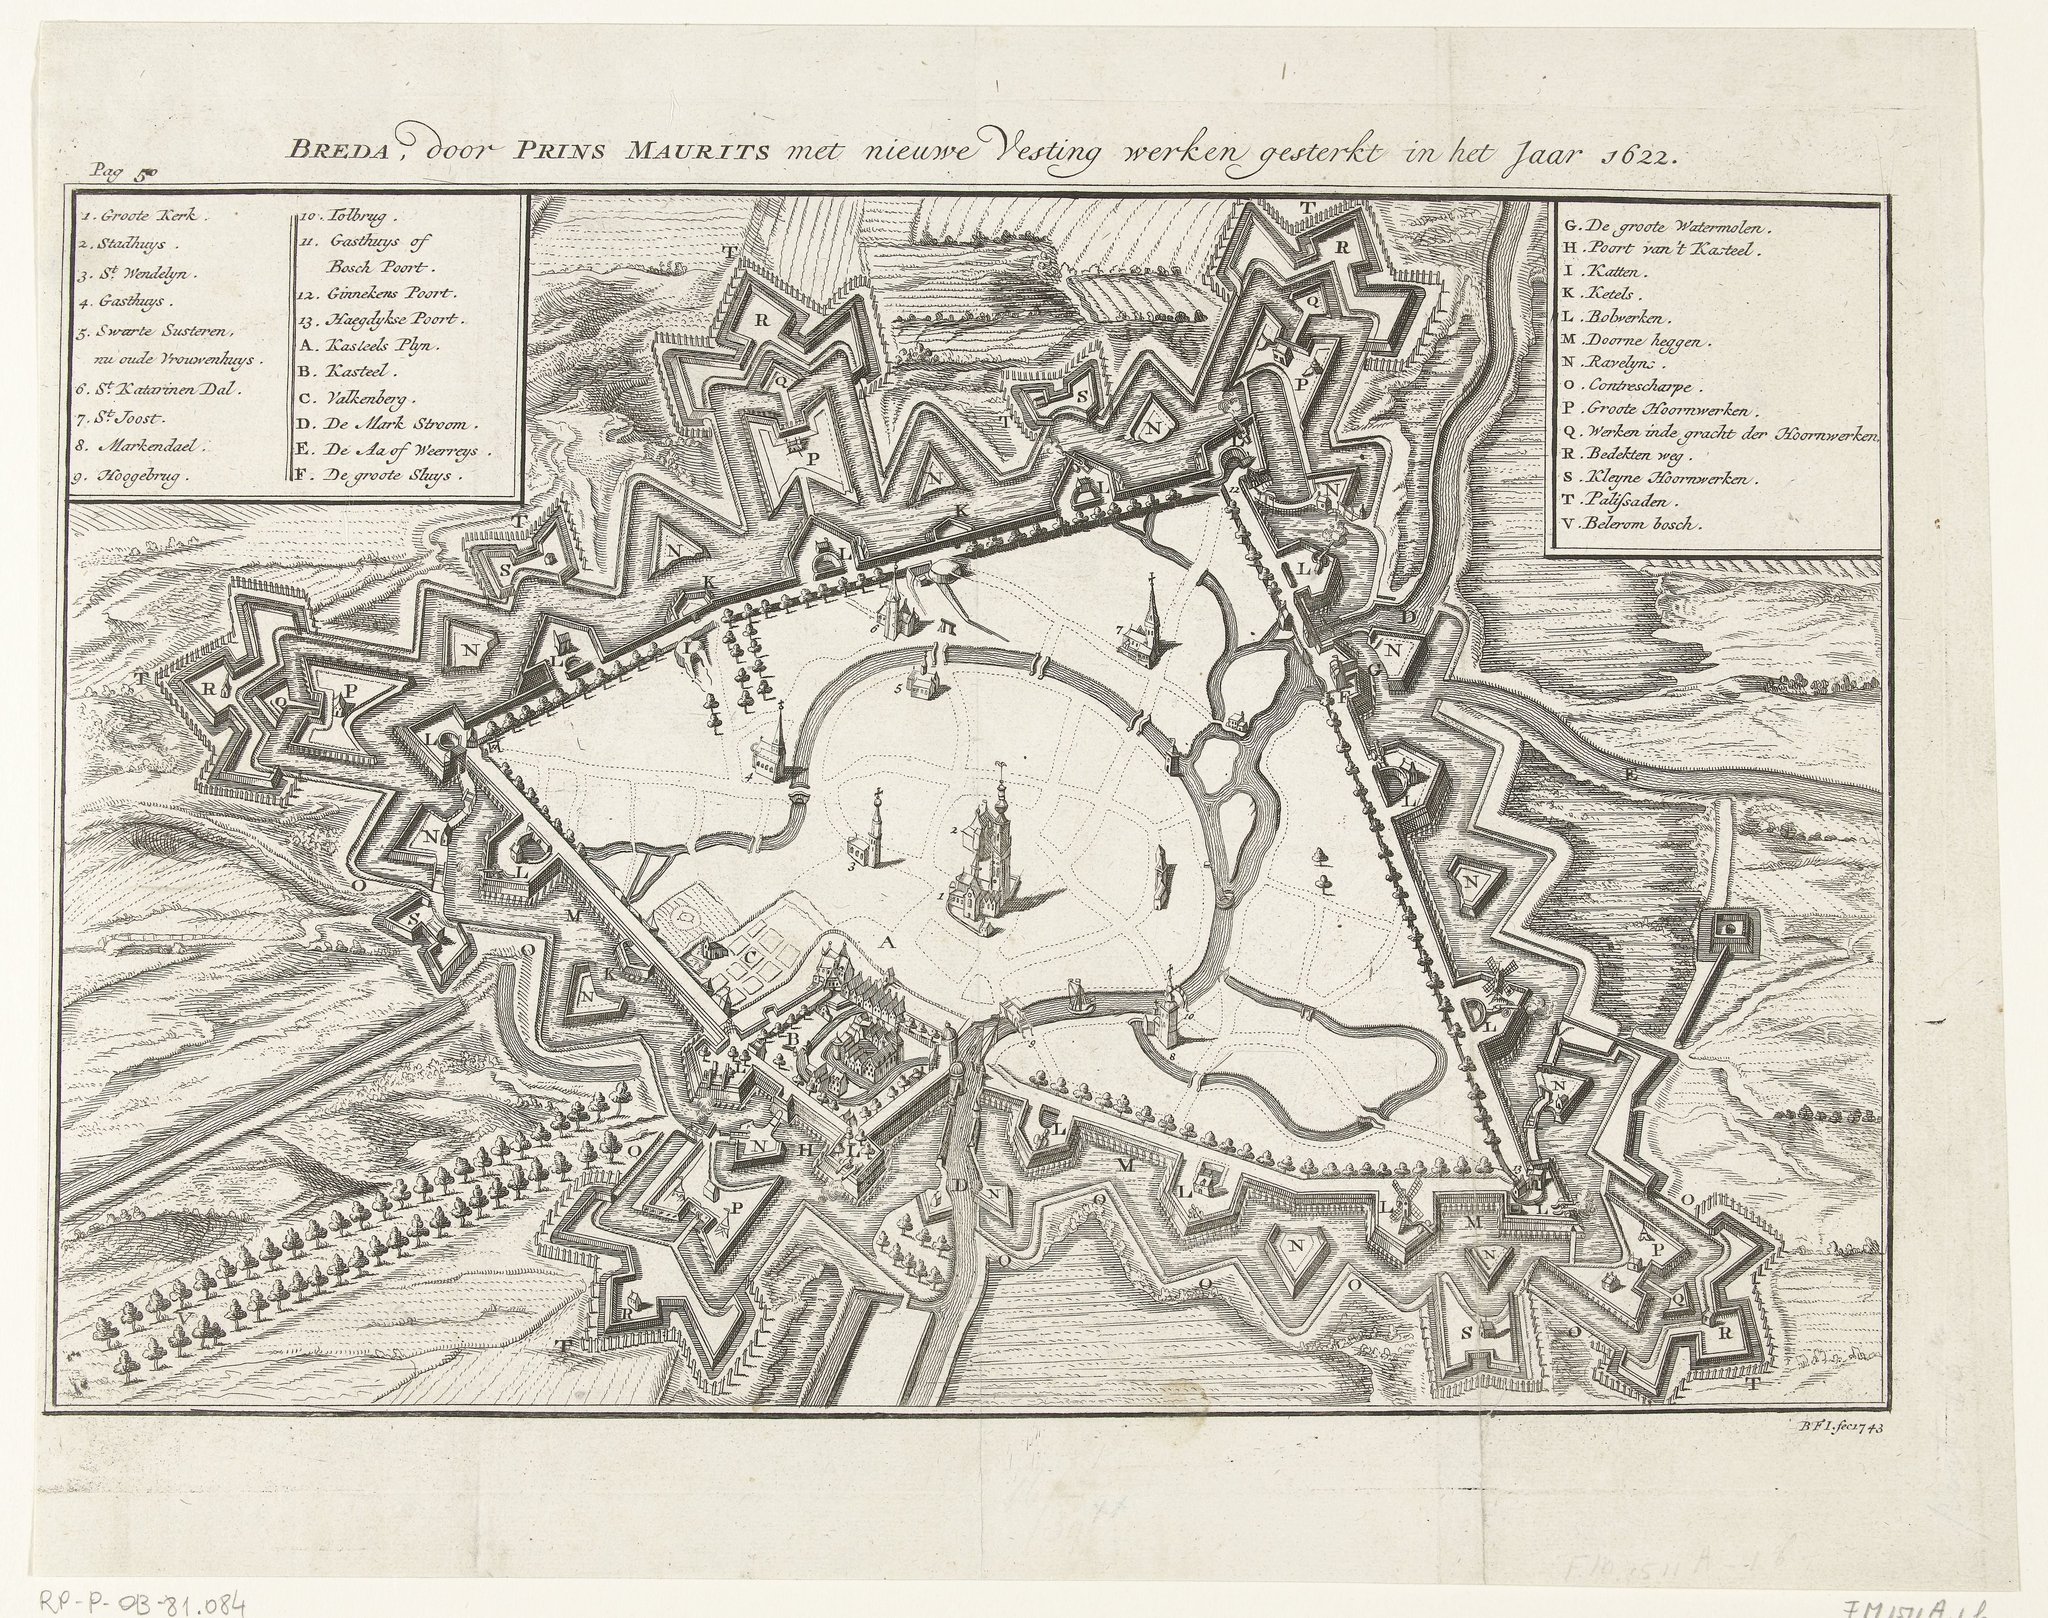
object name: print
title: Versterkingen rond Breda in 1622 door Maurits aangelegd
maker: b.f. immink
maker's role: print maker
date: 1743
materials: paper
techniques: etching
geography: northern netherlands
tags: maurice (prince of orange), fortifications, military engineering, maps of cities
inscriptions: date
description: Gebruikt als illustratie in: Thomas Ernst van Goor, Beschryving der stadt en lande van Breda, Jacobus vanden Kieboom, 's-Gravenhage 1744, p. 50. Niet in Frederik Muller; door het RPK toegevoegd nummer.